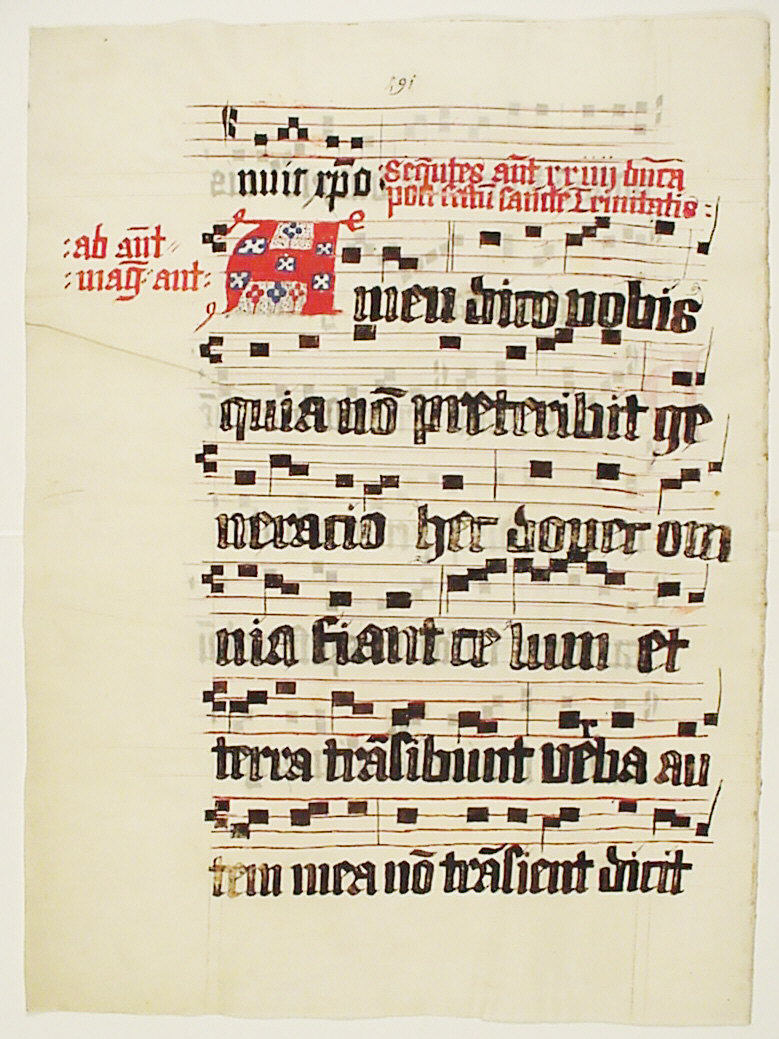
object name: antiphonary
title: Manuscript Leaf with Initial A, from an Antiphonary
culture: german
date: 1426-1450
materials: ink, metal leaf, parchment, paint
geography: germany